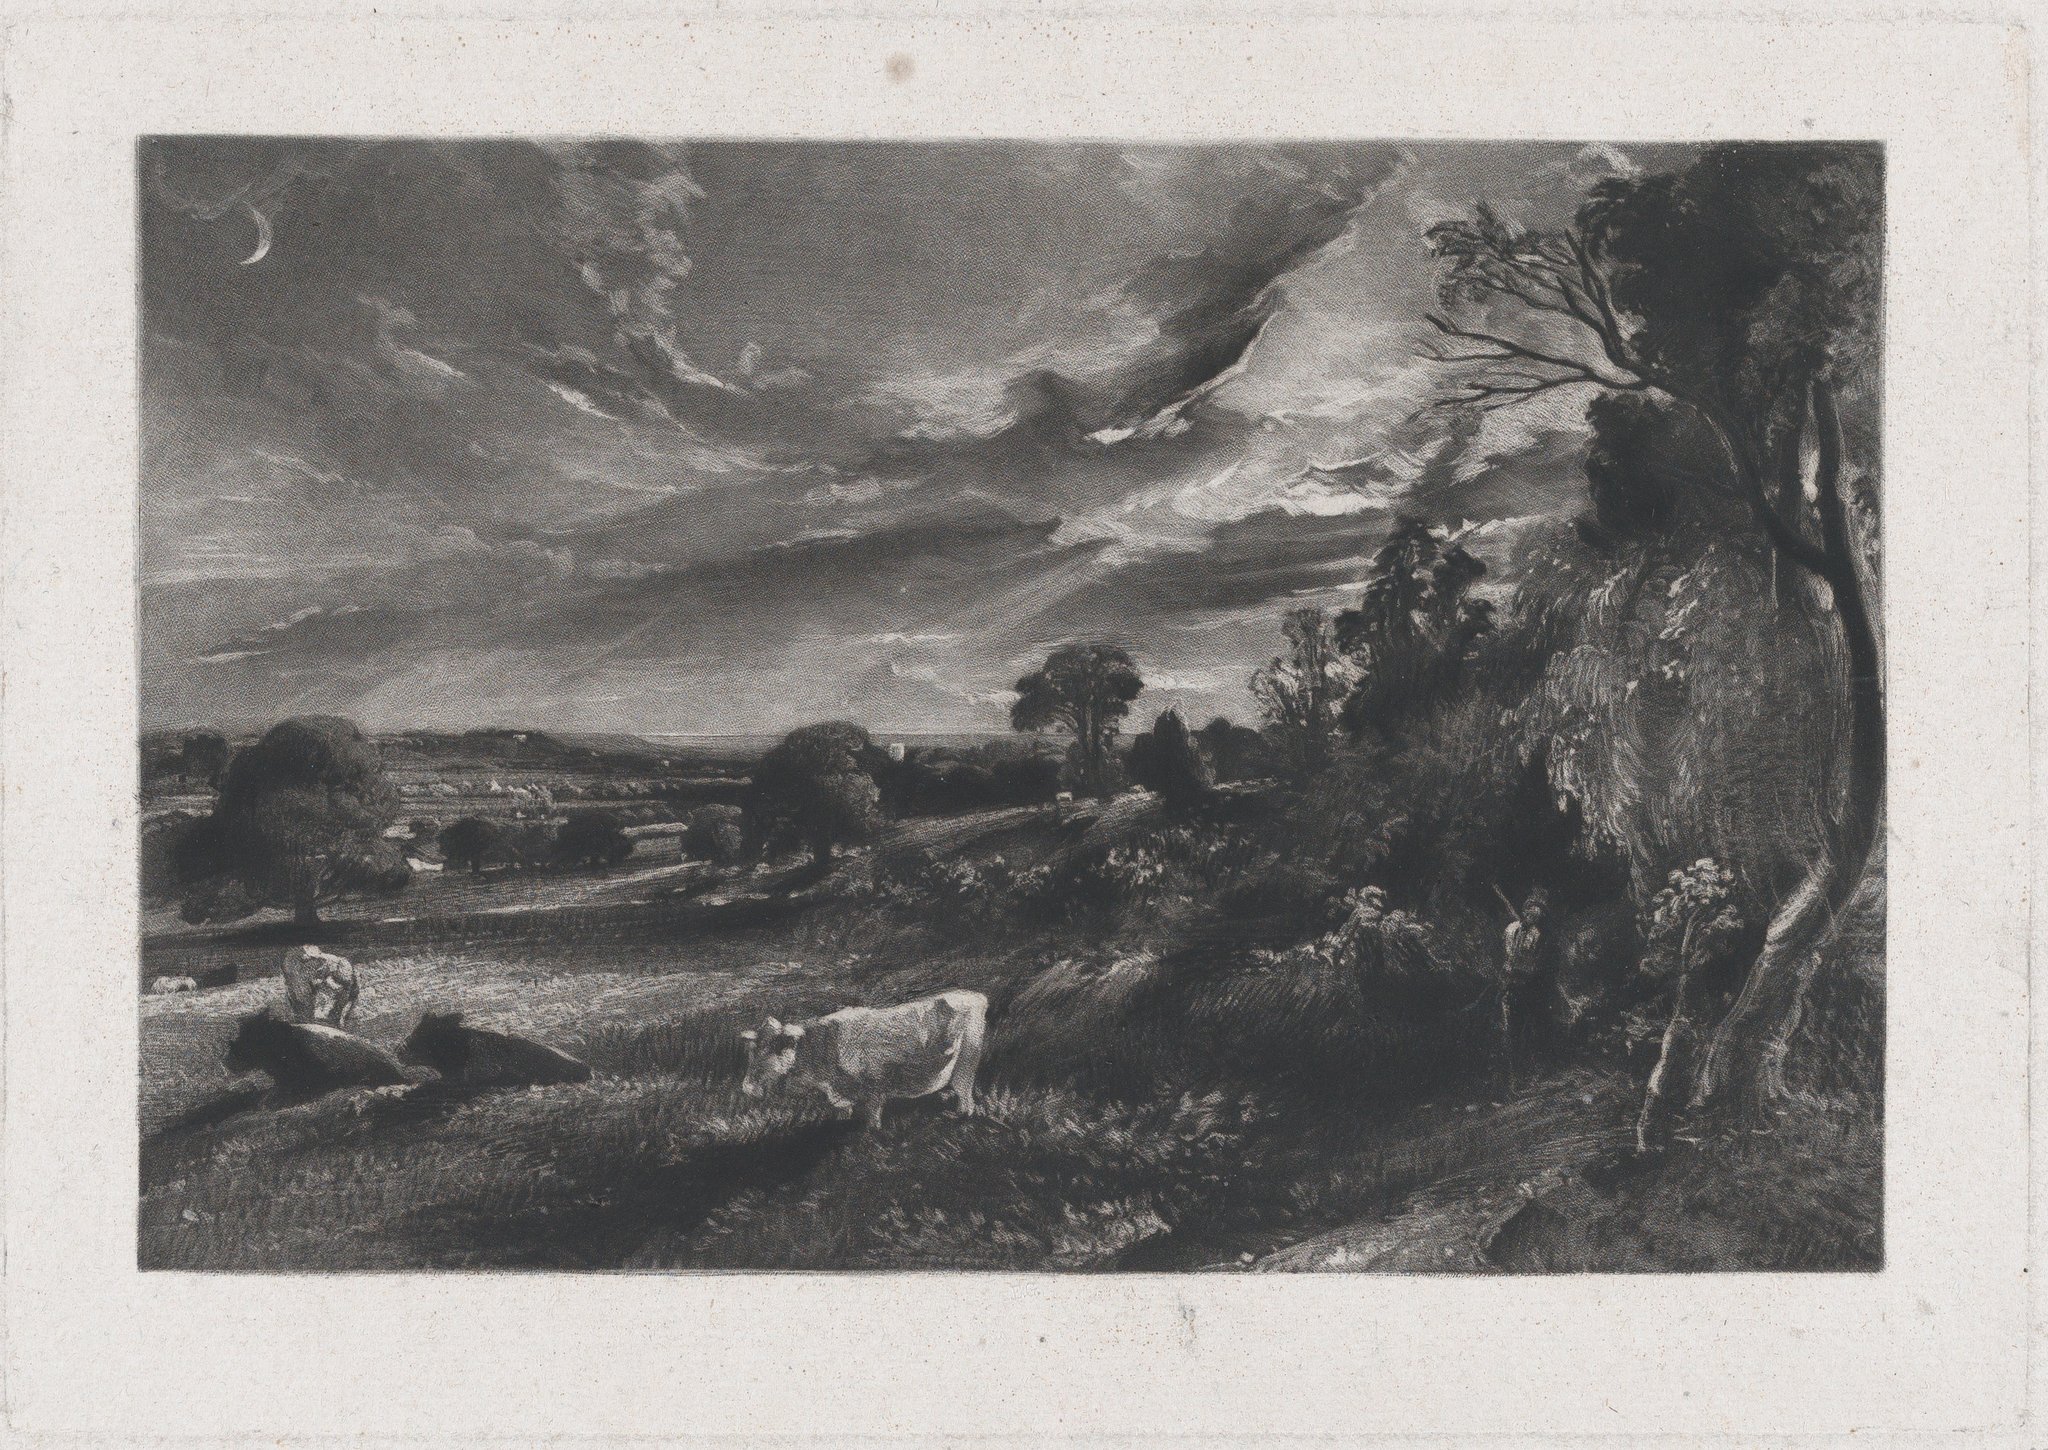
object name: print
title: Summer Evening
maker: david lucas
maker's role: artist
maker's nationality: british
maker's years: 1802-1881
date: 1829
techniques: mezzotint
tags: cows,landscapes,pastoral,summer,evening